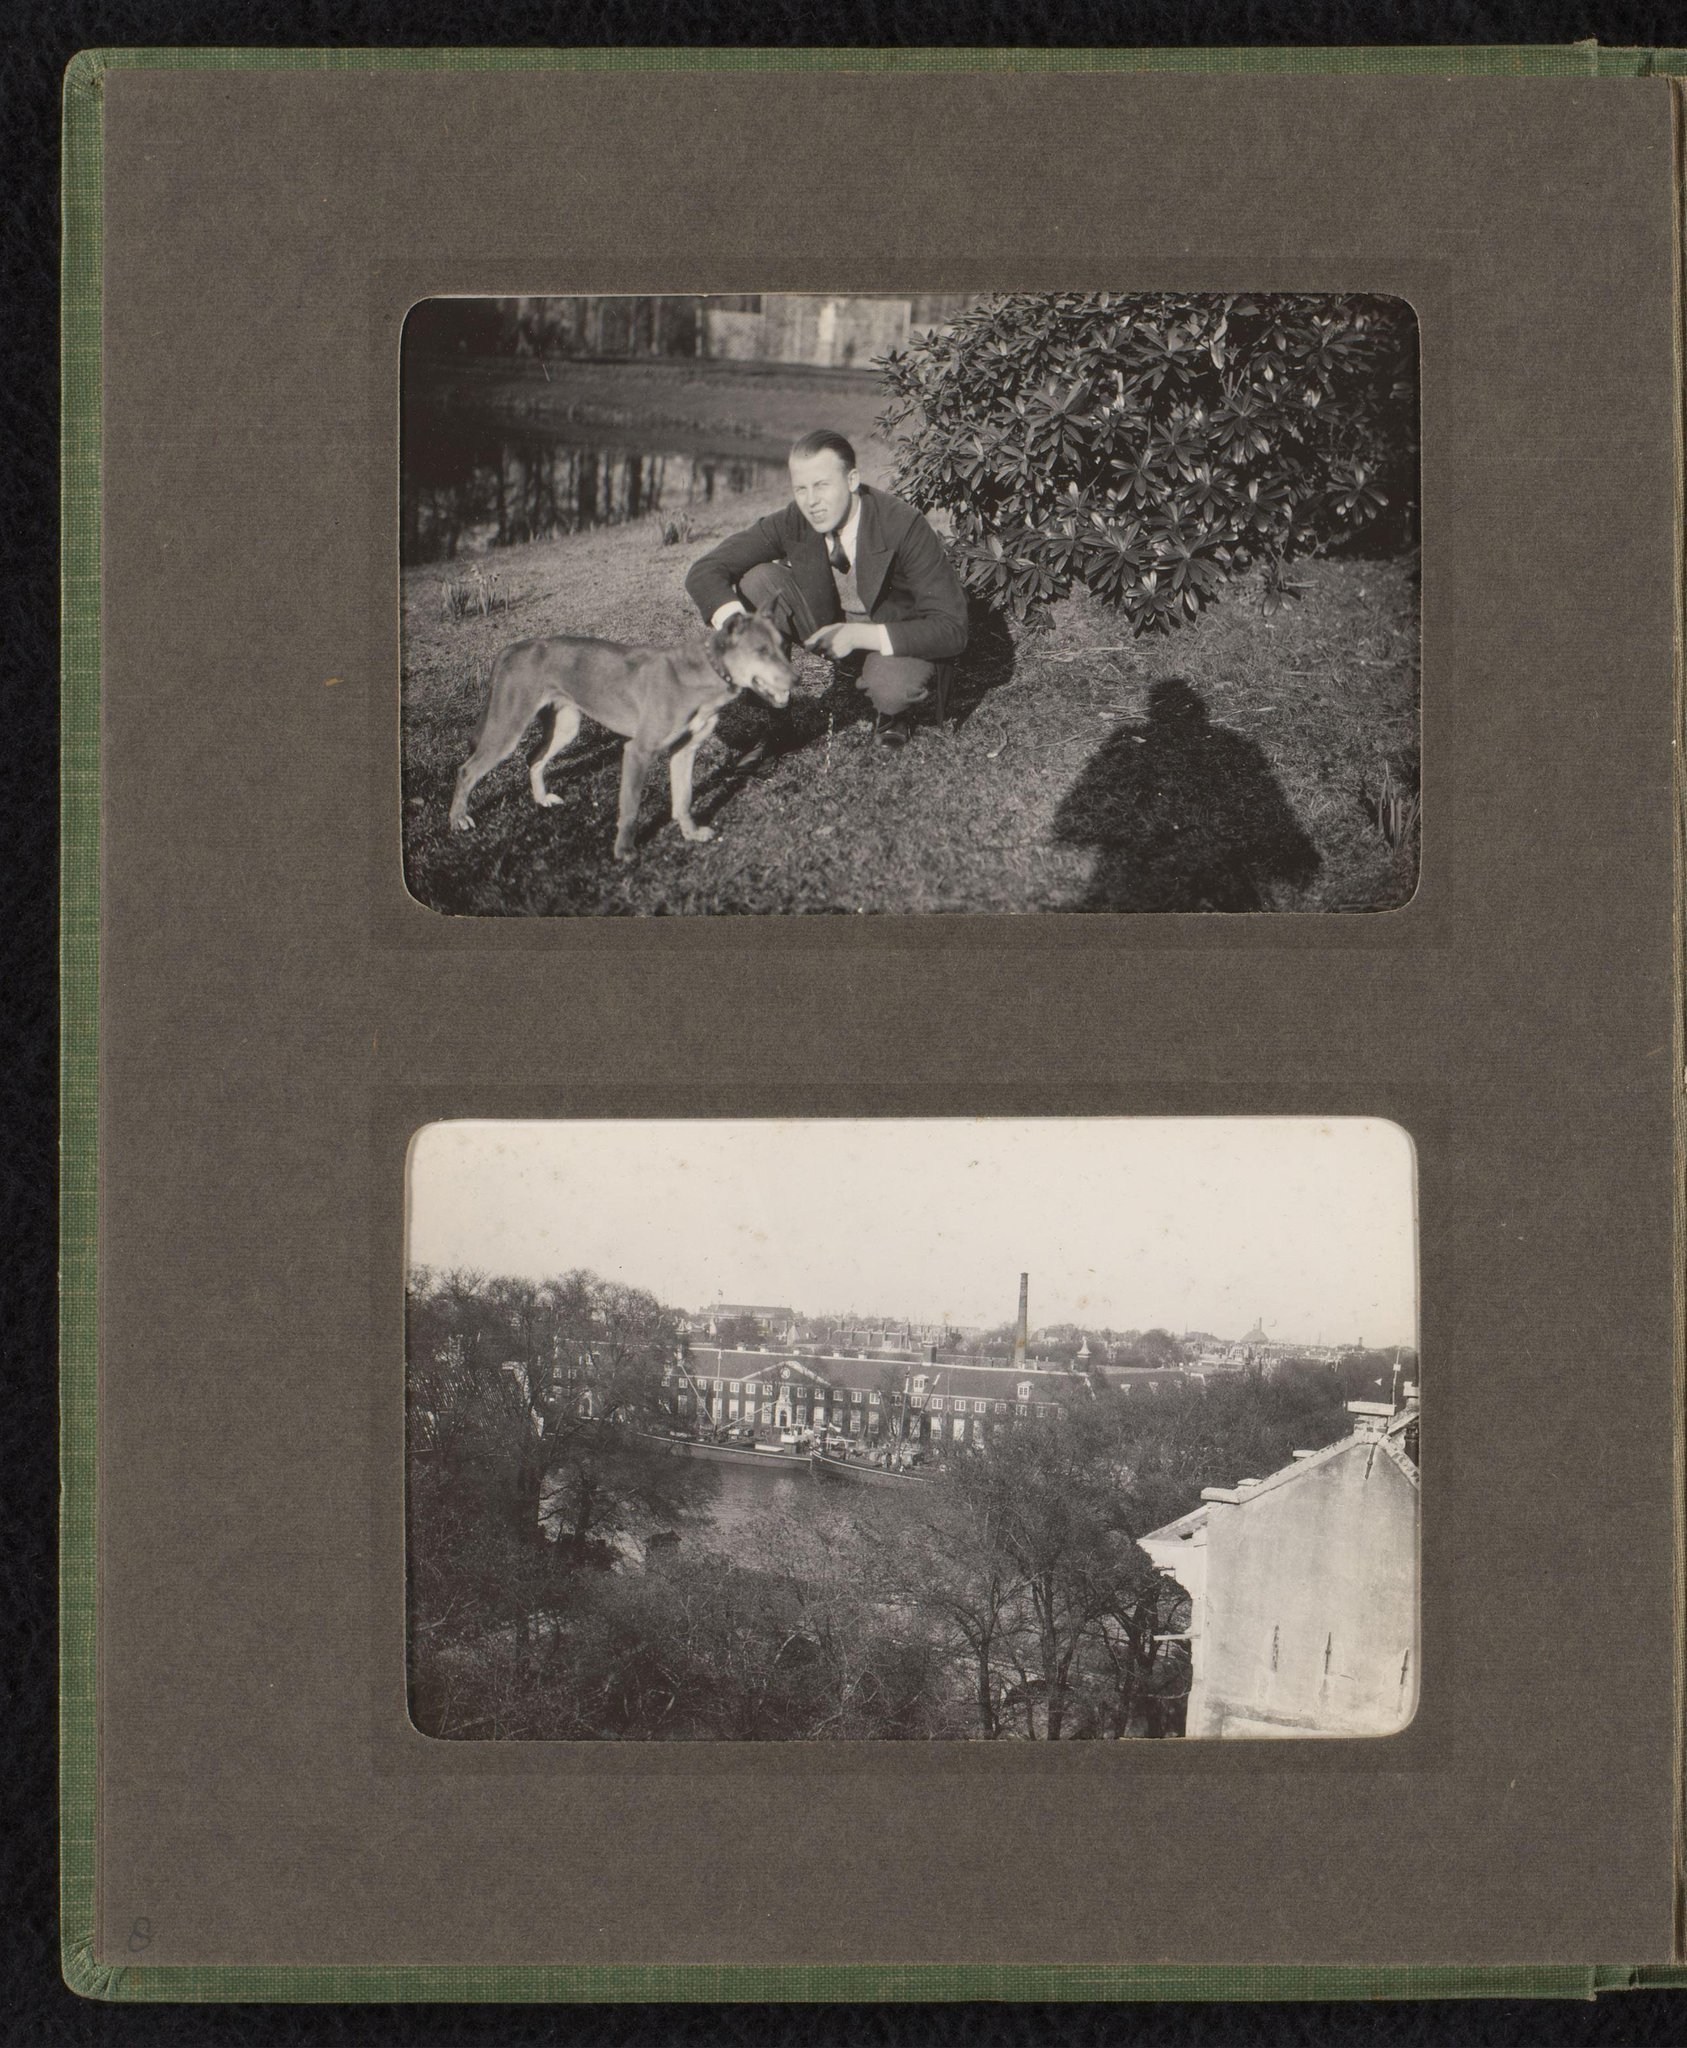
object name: photograph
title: Twee foto's van Frank van den Berg met een hond en een gezicht op de Amstelhof te Amsterdam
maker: frank willem van den berg (1912-1998)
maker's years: 1912-1998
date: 1932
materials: paper, cardboard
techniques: gelatin silver print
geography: amsterdam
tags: amsterdam, frank willem van den berg (1912-1998), city-view in general; 'veduta', historical persons, dog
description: Deze foto's maken deel uit van een album.